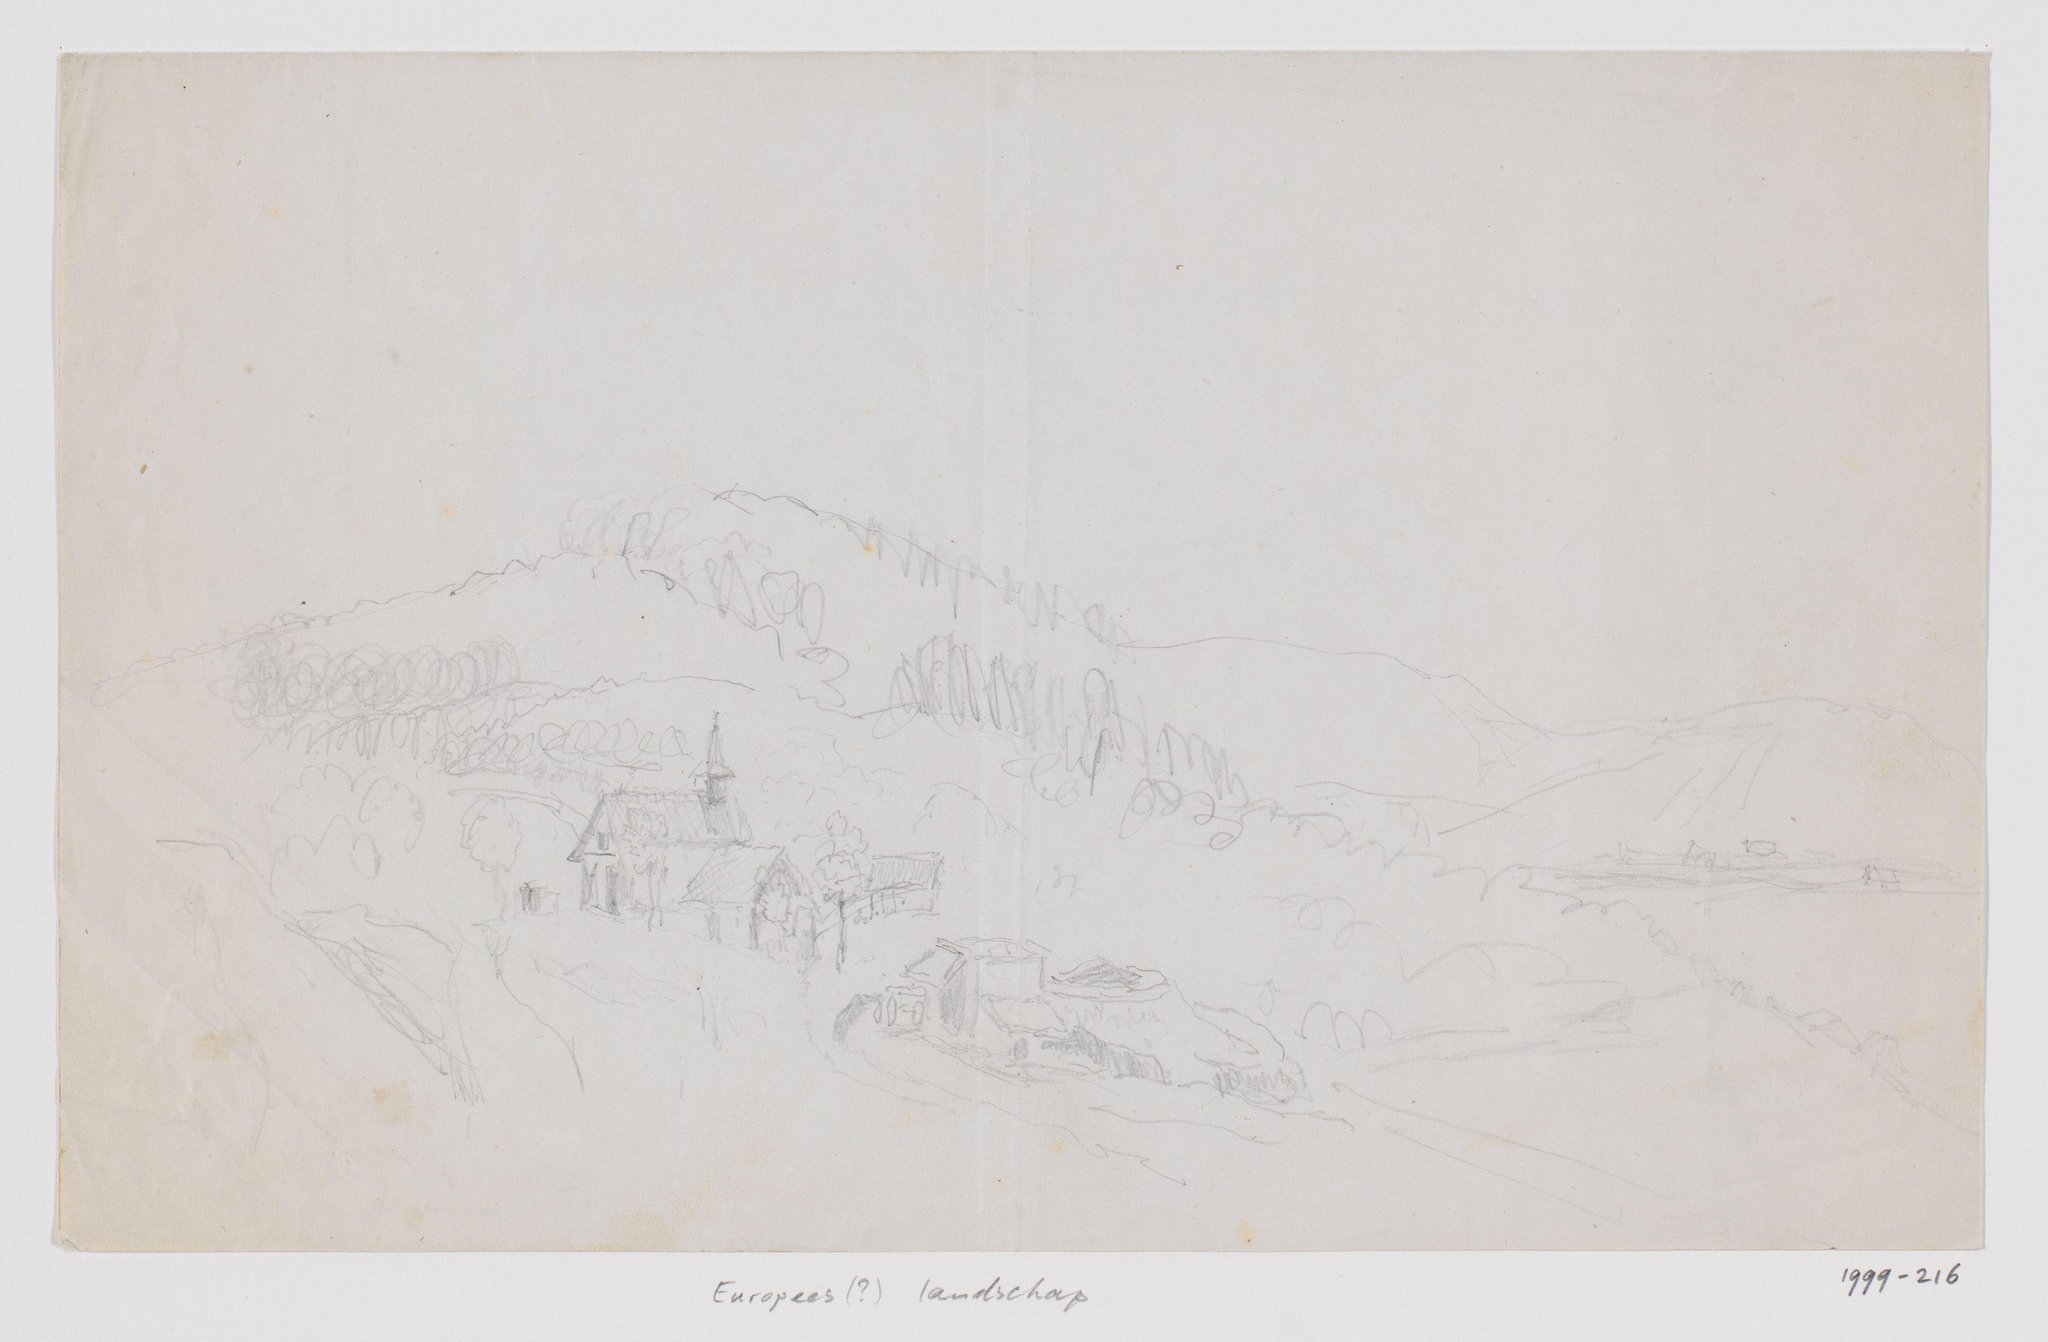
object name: drawing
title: Europees (?) landschap met kerkje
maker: adrianus johannes bik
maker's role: draughtsman, print maker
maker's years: 1790-1872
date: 1846-1872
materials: paper, pencil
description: artikel over deze collectie in Bulletin van het Rijksmuseum 49 [2001], nr. 4, pp 342 e.v.